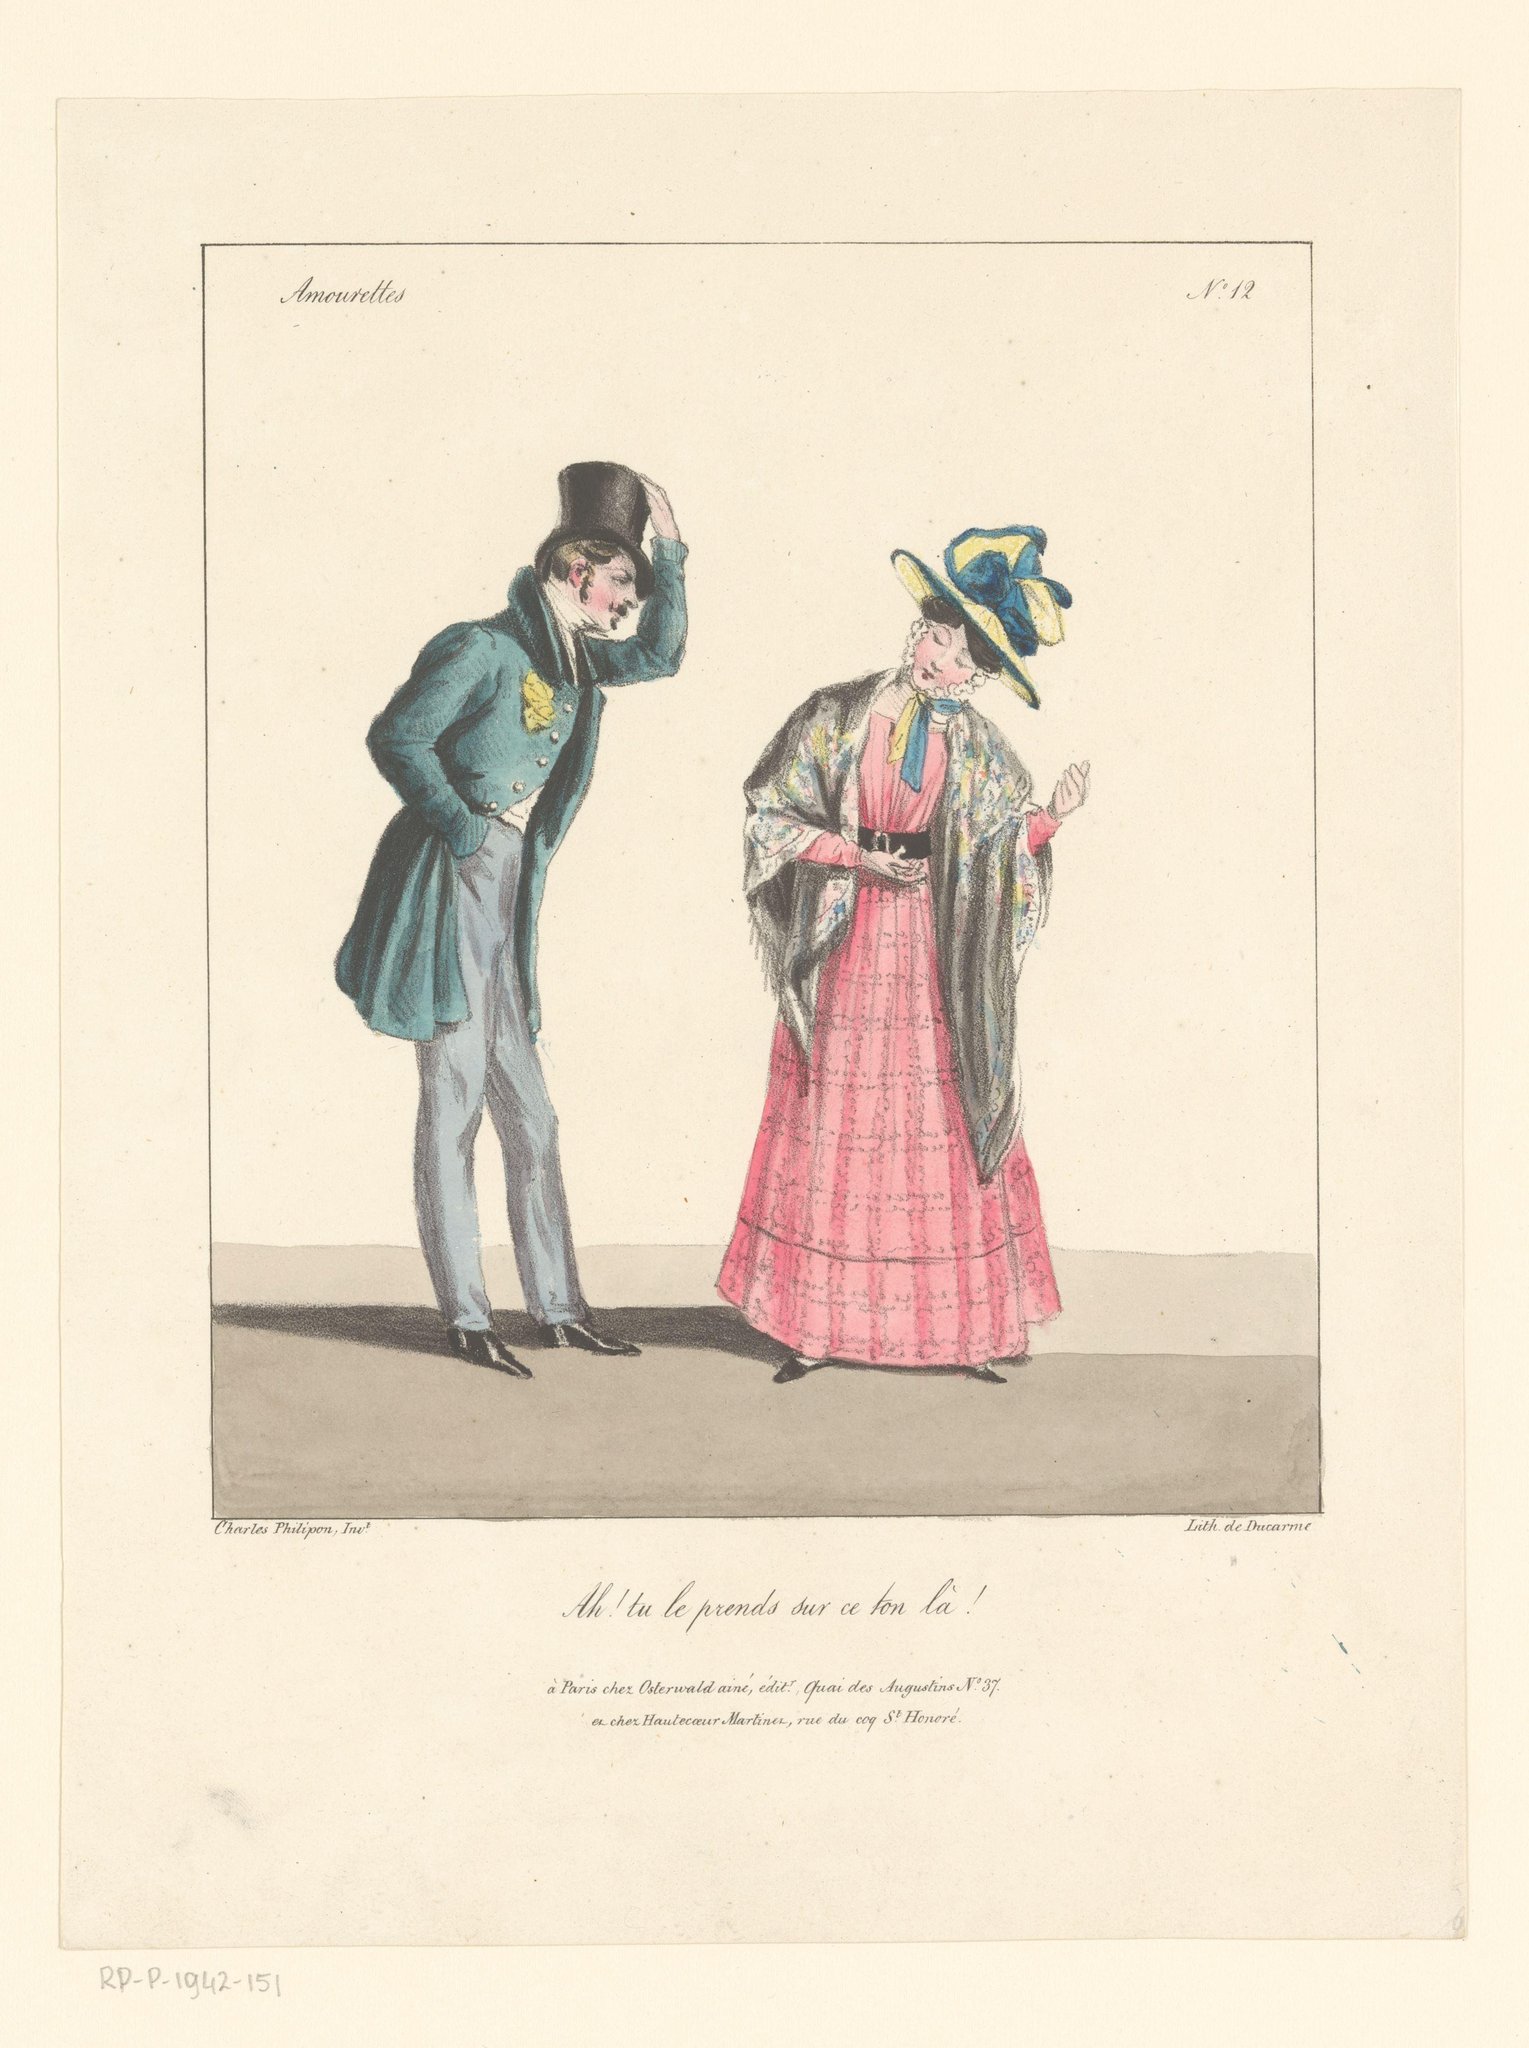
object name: print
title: Liefdestaferelen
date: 1827-1829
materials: paper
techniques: hand coloring, lithograph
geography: paris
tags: fashion, clothing, adult woman, adult man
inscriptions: collector's mark: Lugt 2228, collector's mark: Lugt 2760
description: Serie bestond in eerste instantie uit achttien prenten maar is later uitgebreid, onduidelijk naar hoeveel prenten precies.